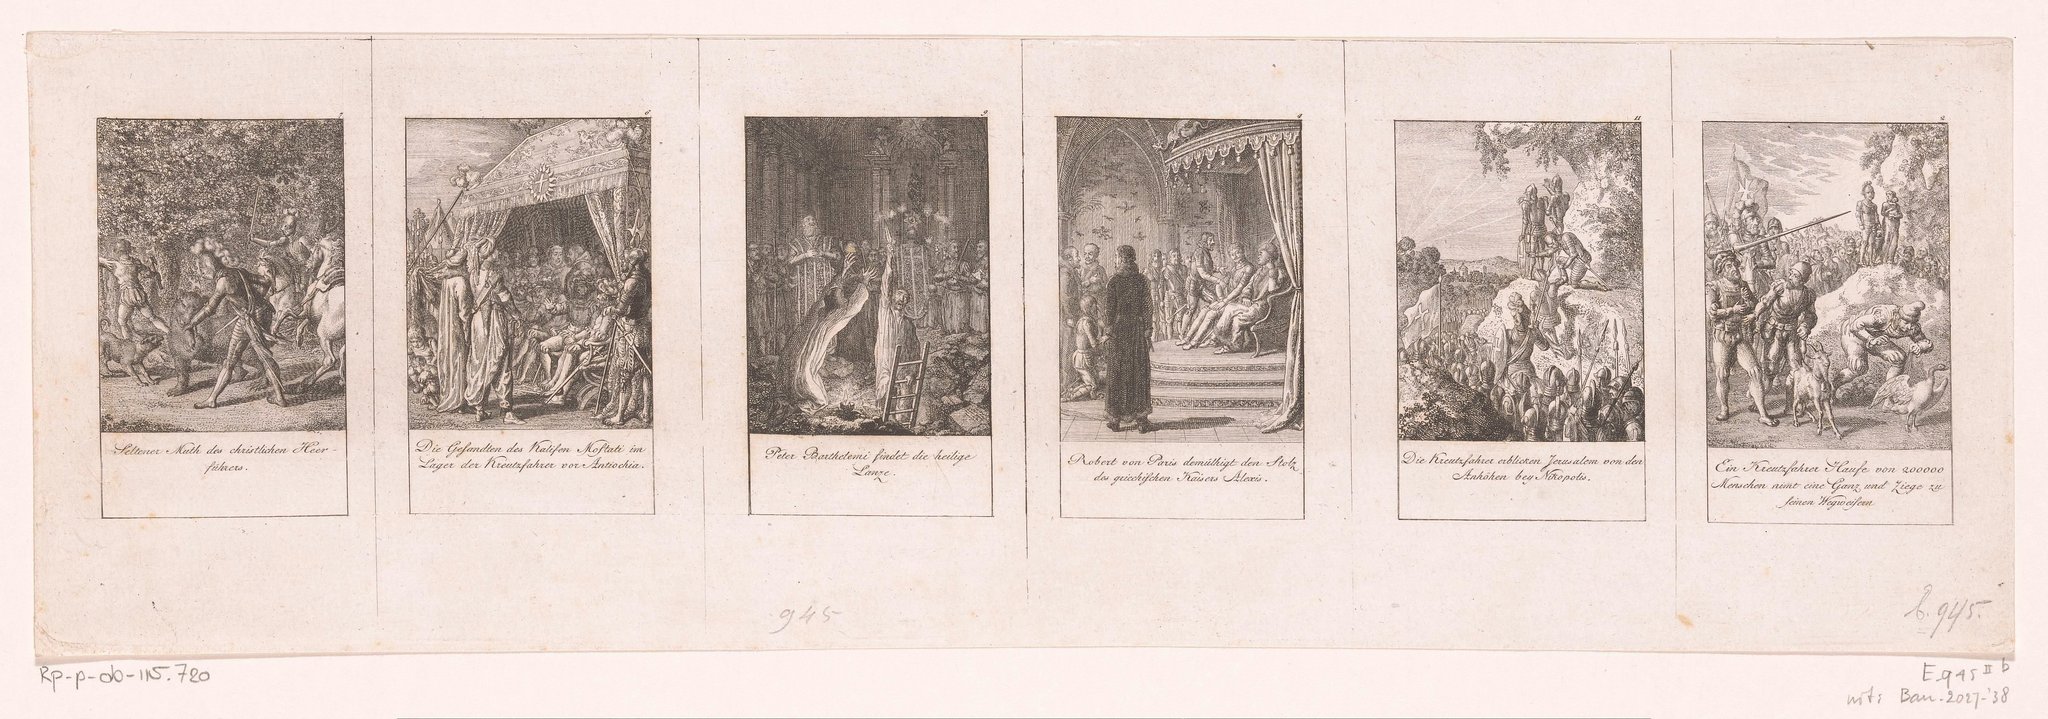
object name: print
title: Zes voorstellingen uit de geschiedenis van de eerste kruistocht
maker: daniel nikolaus chodowiecki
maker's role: draughtsman, print maker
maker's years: 1726-1801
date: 1800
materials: paper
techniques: etching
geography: berlin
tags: godfrey of bouillon, the holy lance ~ relics of christ, ordeal by fire or heat, militant proselytizing: religious war, crusade, etc., preaching (in general), seeking death, suicide, fighting, the jews, jewish life, man killing animal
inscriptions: collector's mark: Lugt 2228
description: Prenten gebruikt voor: Historisch-genealogischer Kalender auf das Gemeinjahr 1801. Abriss einer Geschichte des ersten Kreuzzuges der Christen nach Palästina (...). Berlijn: Johann Friedrich Unger, s.a.